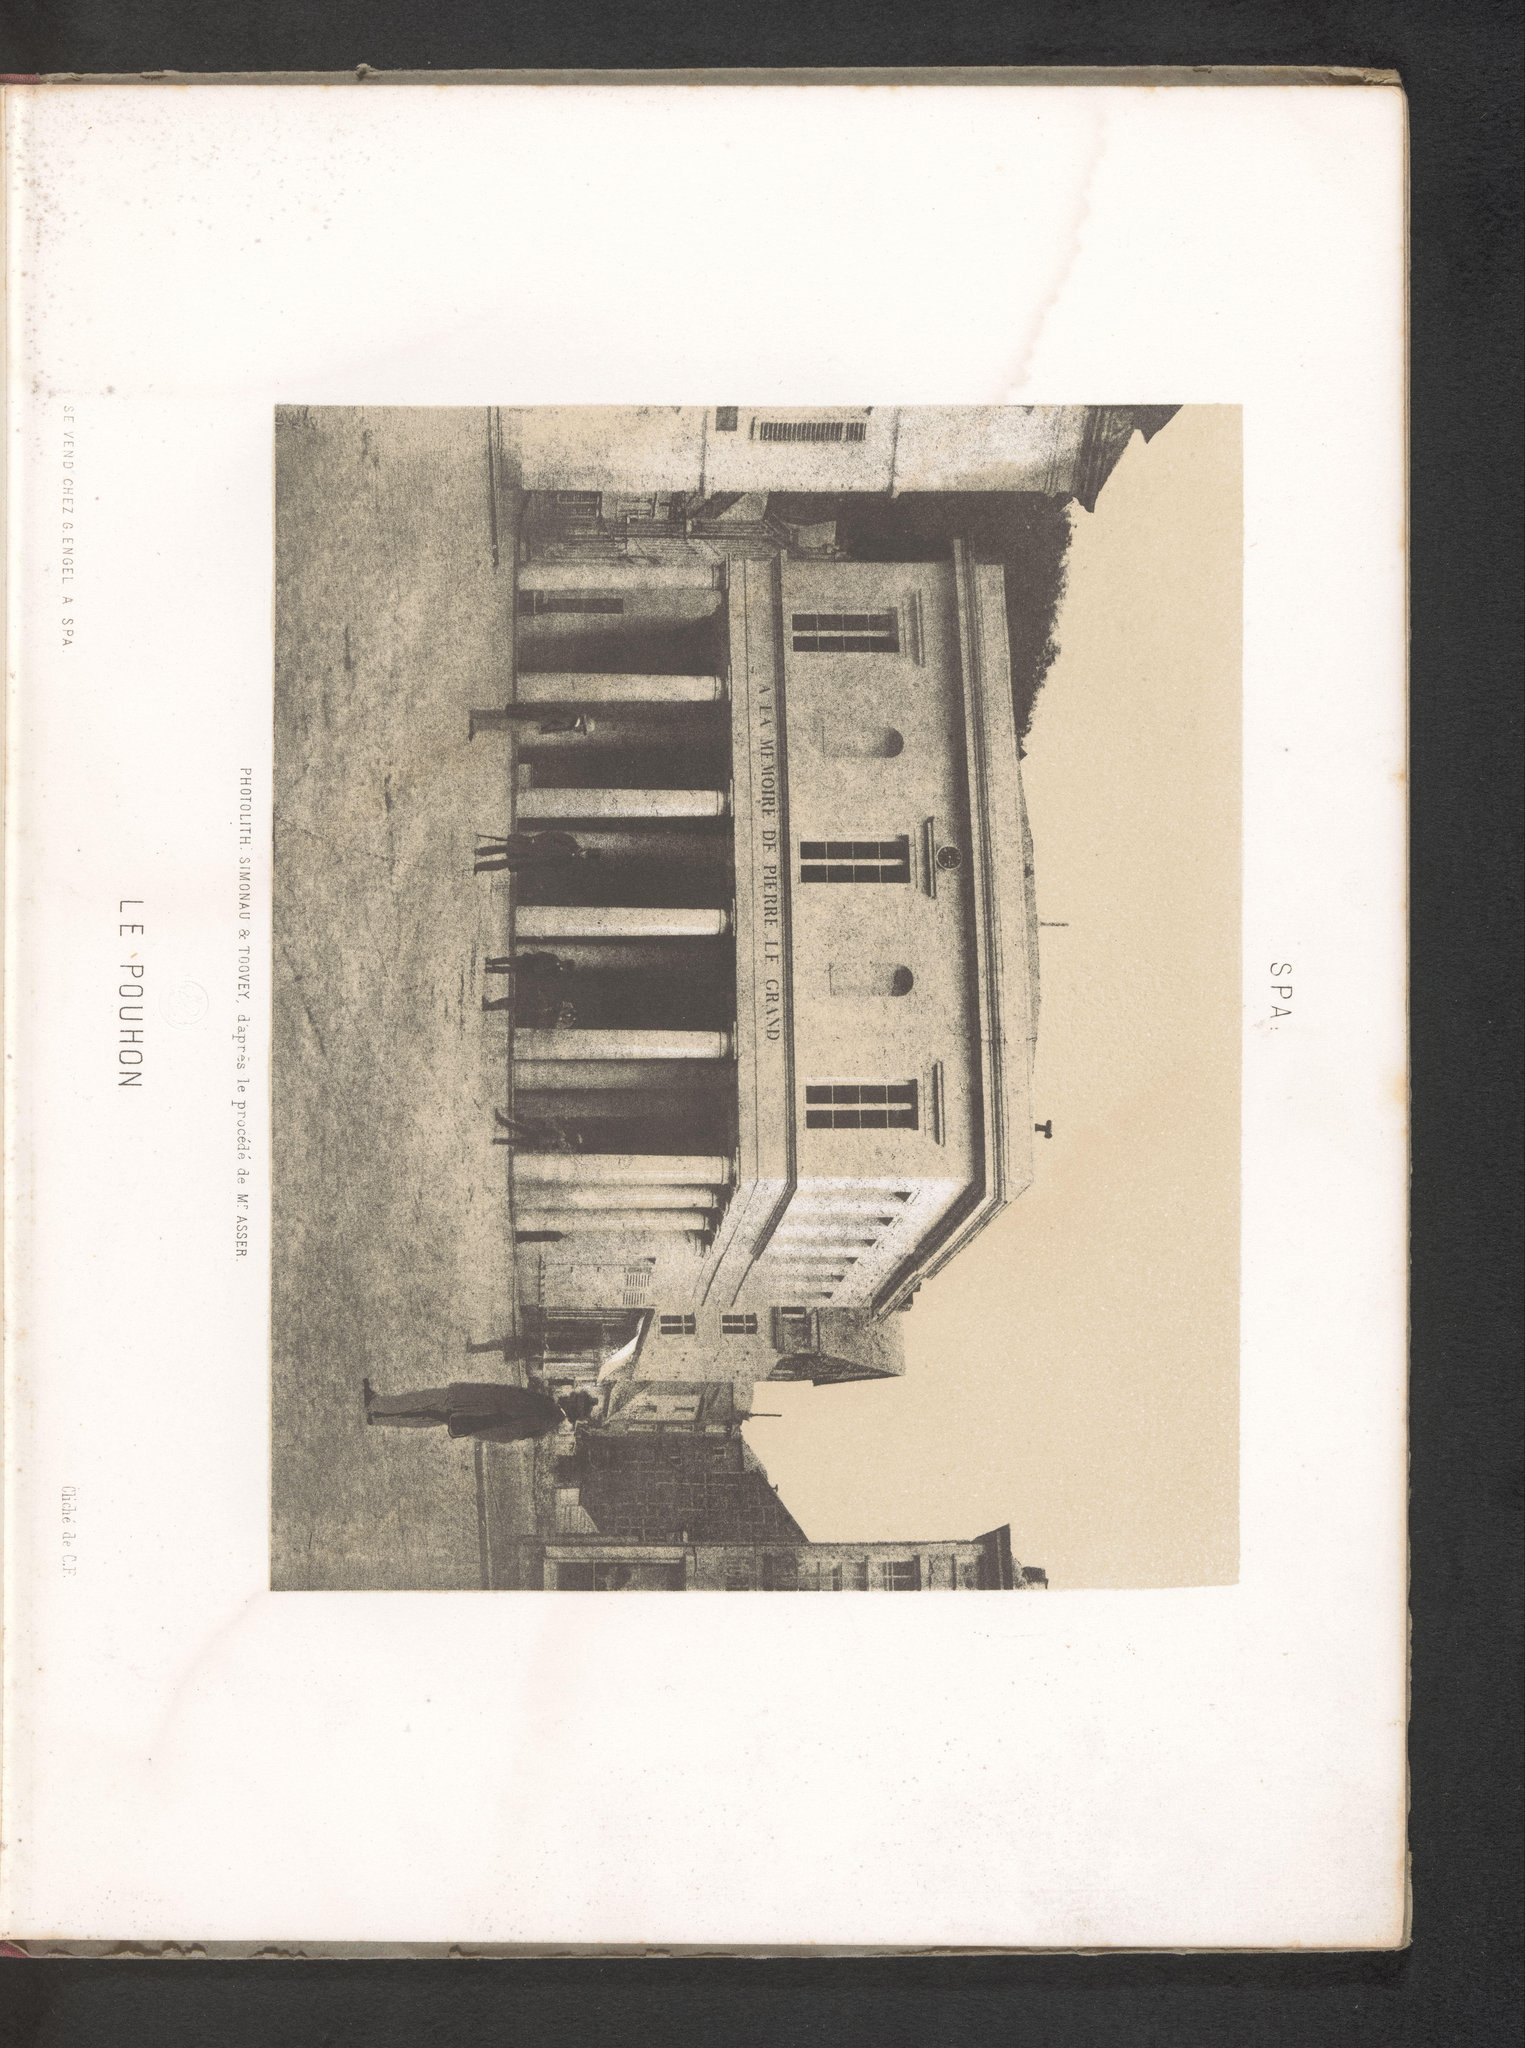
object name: photomechanical print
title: Spa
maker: c.f.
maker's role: fotograaf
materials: paper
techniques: photolithography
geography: spa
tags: square, place, circus, etc., spring (fluids extracted from the earth)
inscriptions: collector's mark: ‘EA’, inscription: ‘SE VEND CHEZ F. ENGEL A SPA.’, inscription: ‘PHOTOLITH. SIMONAU & TOOVEY, d'après le procédé de Mr. ASSER.’